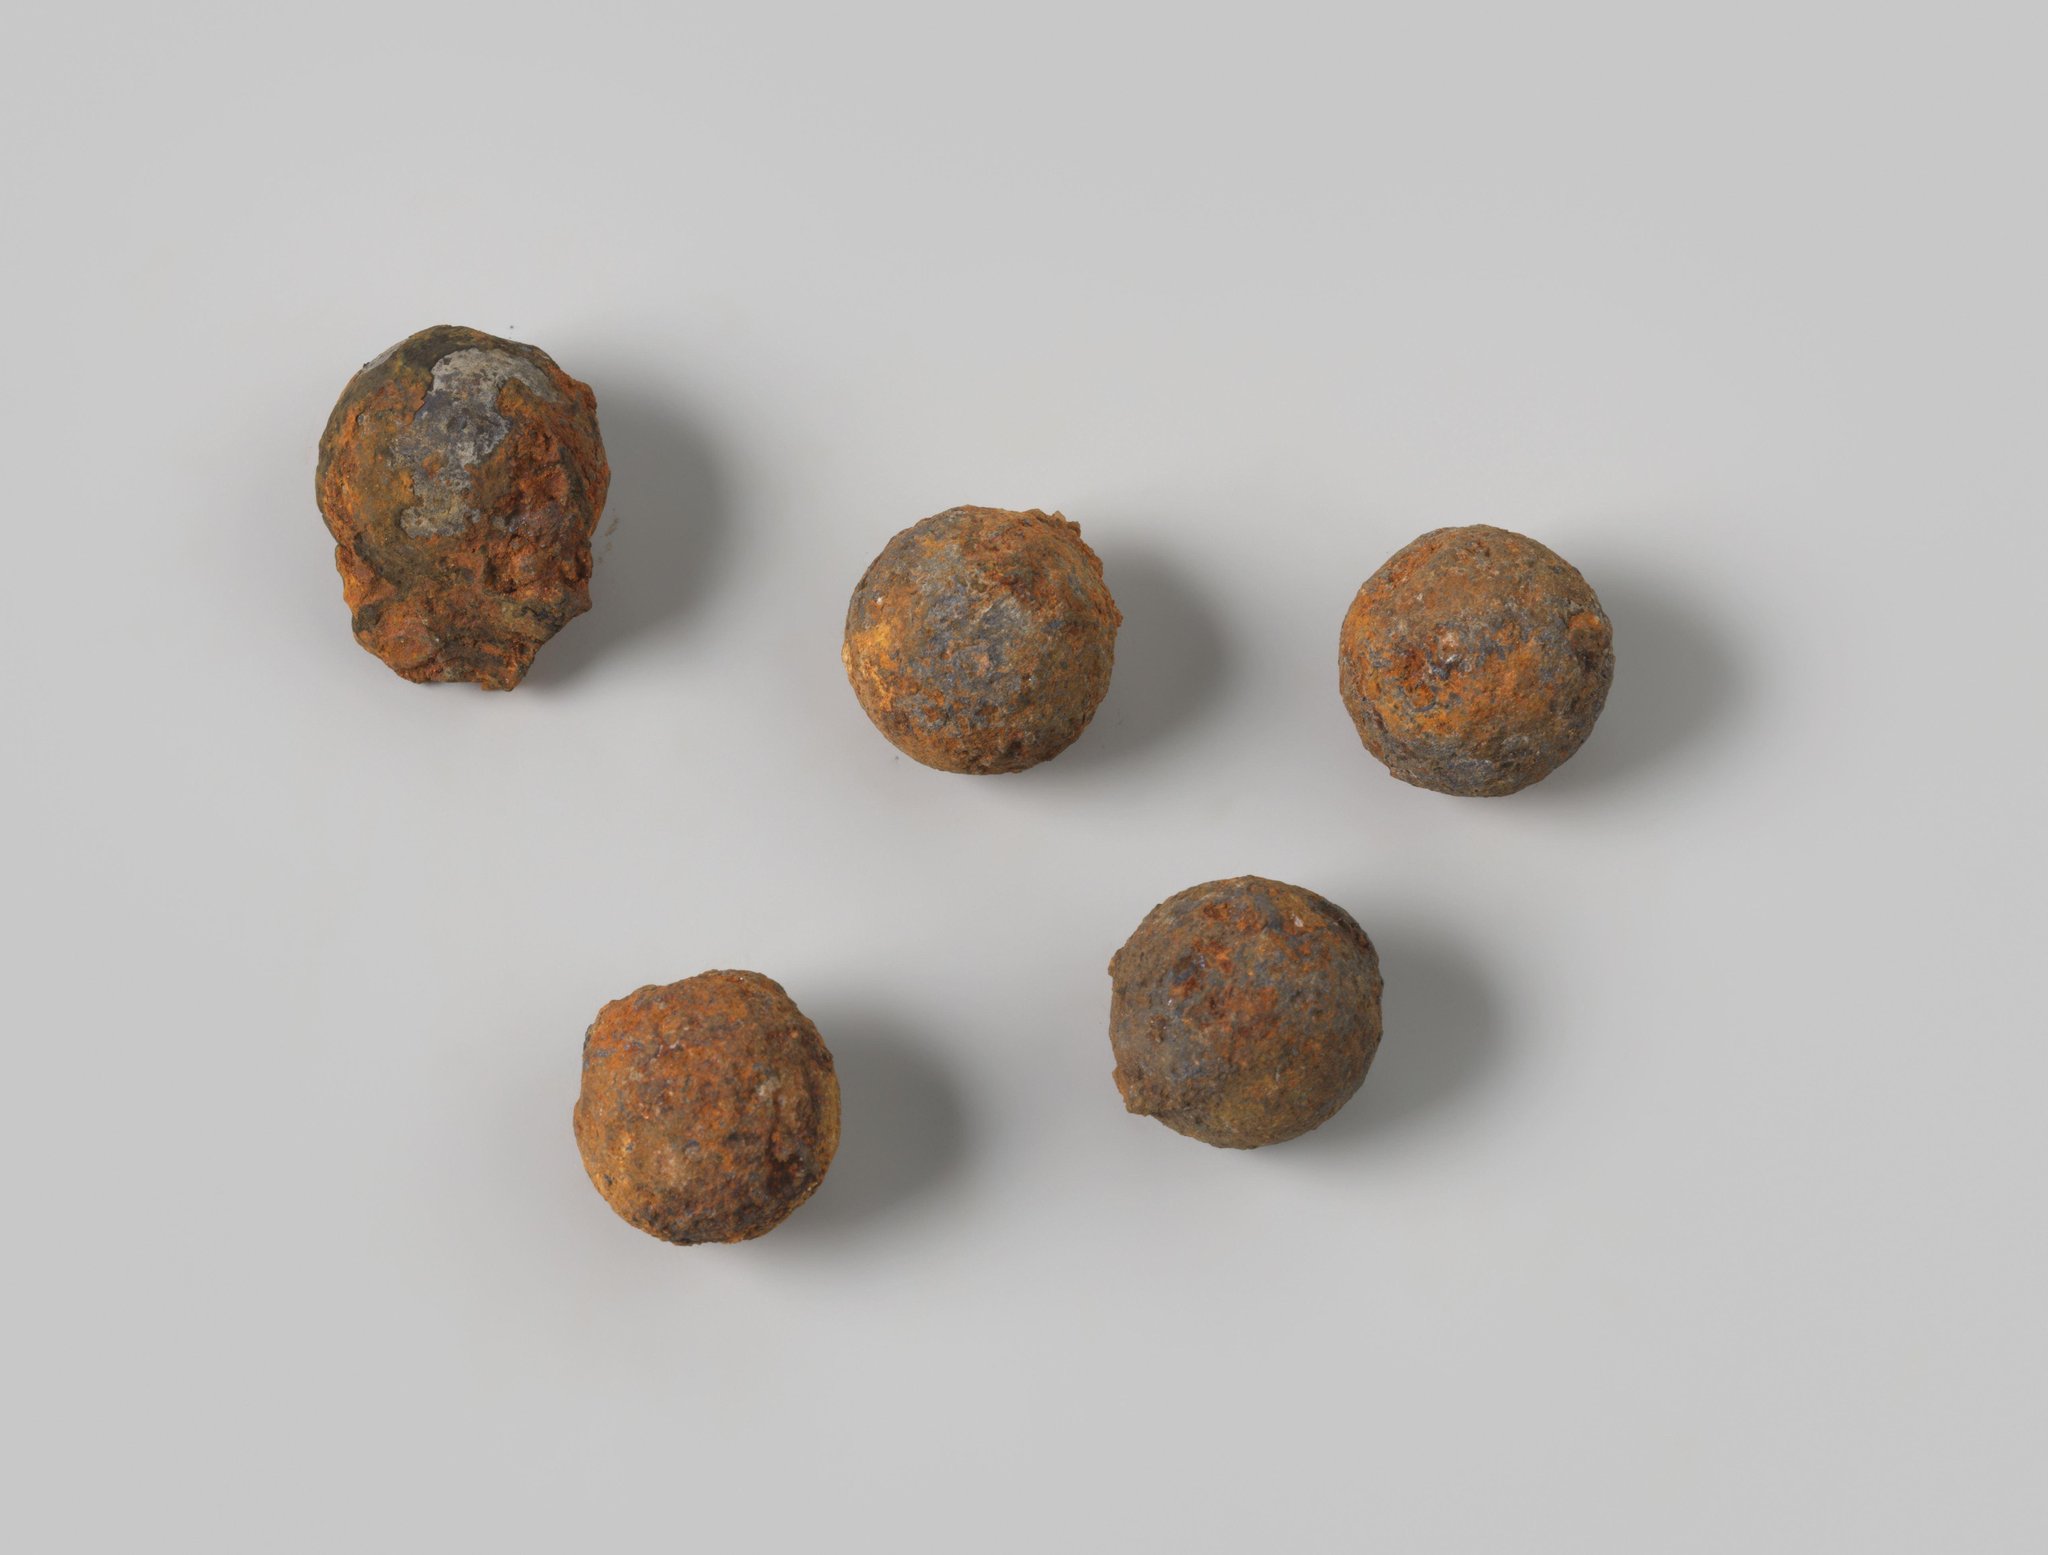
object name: musketkogel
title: Musketkogels uit het wrak van de Oost-Indiëvaarder Hollandia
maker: Anonymous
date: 1700-1743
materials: stone, lead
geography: netherlands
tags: verenigde oostindische compagnie, hollandia (schip), annet